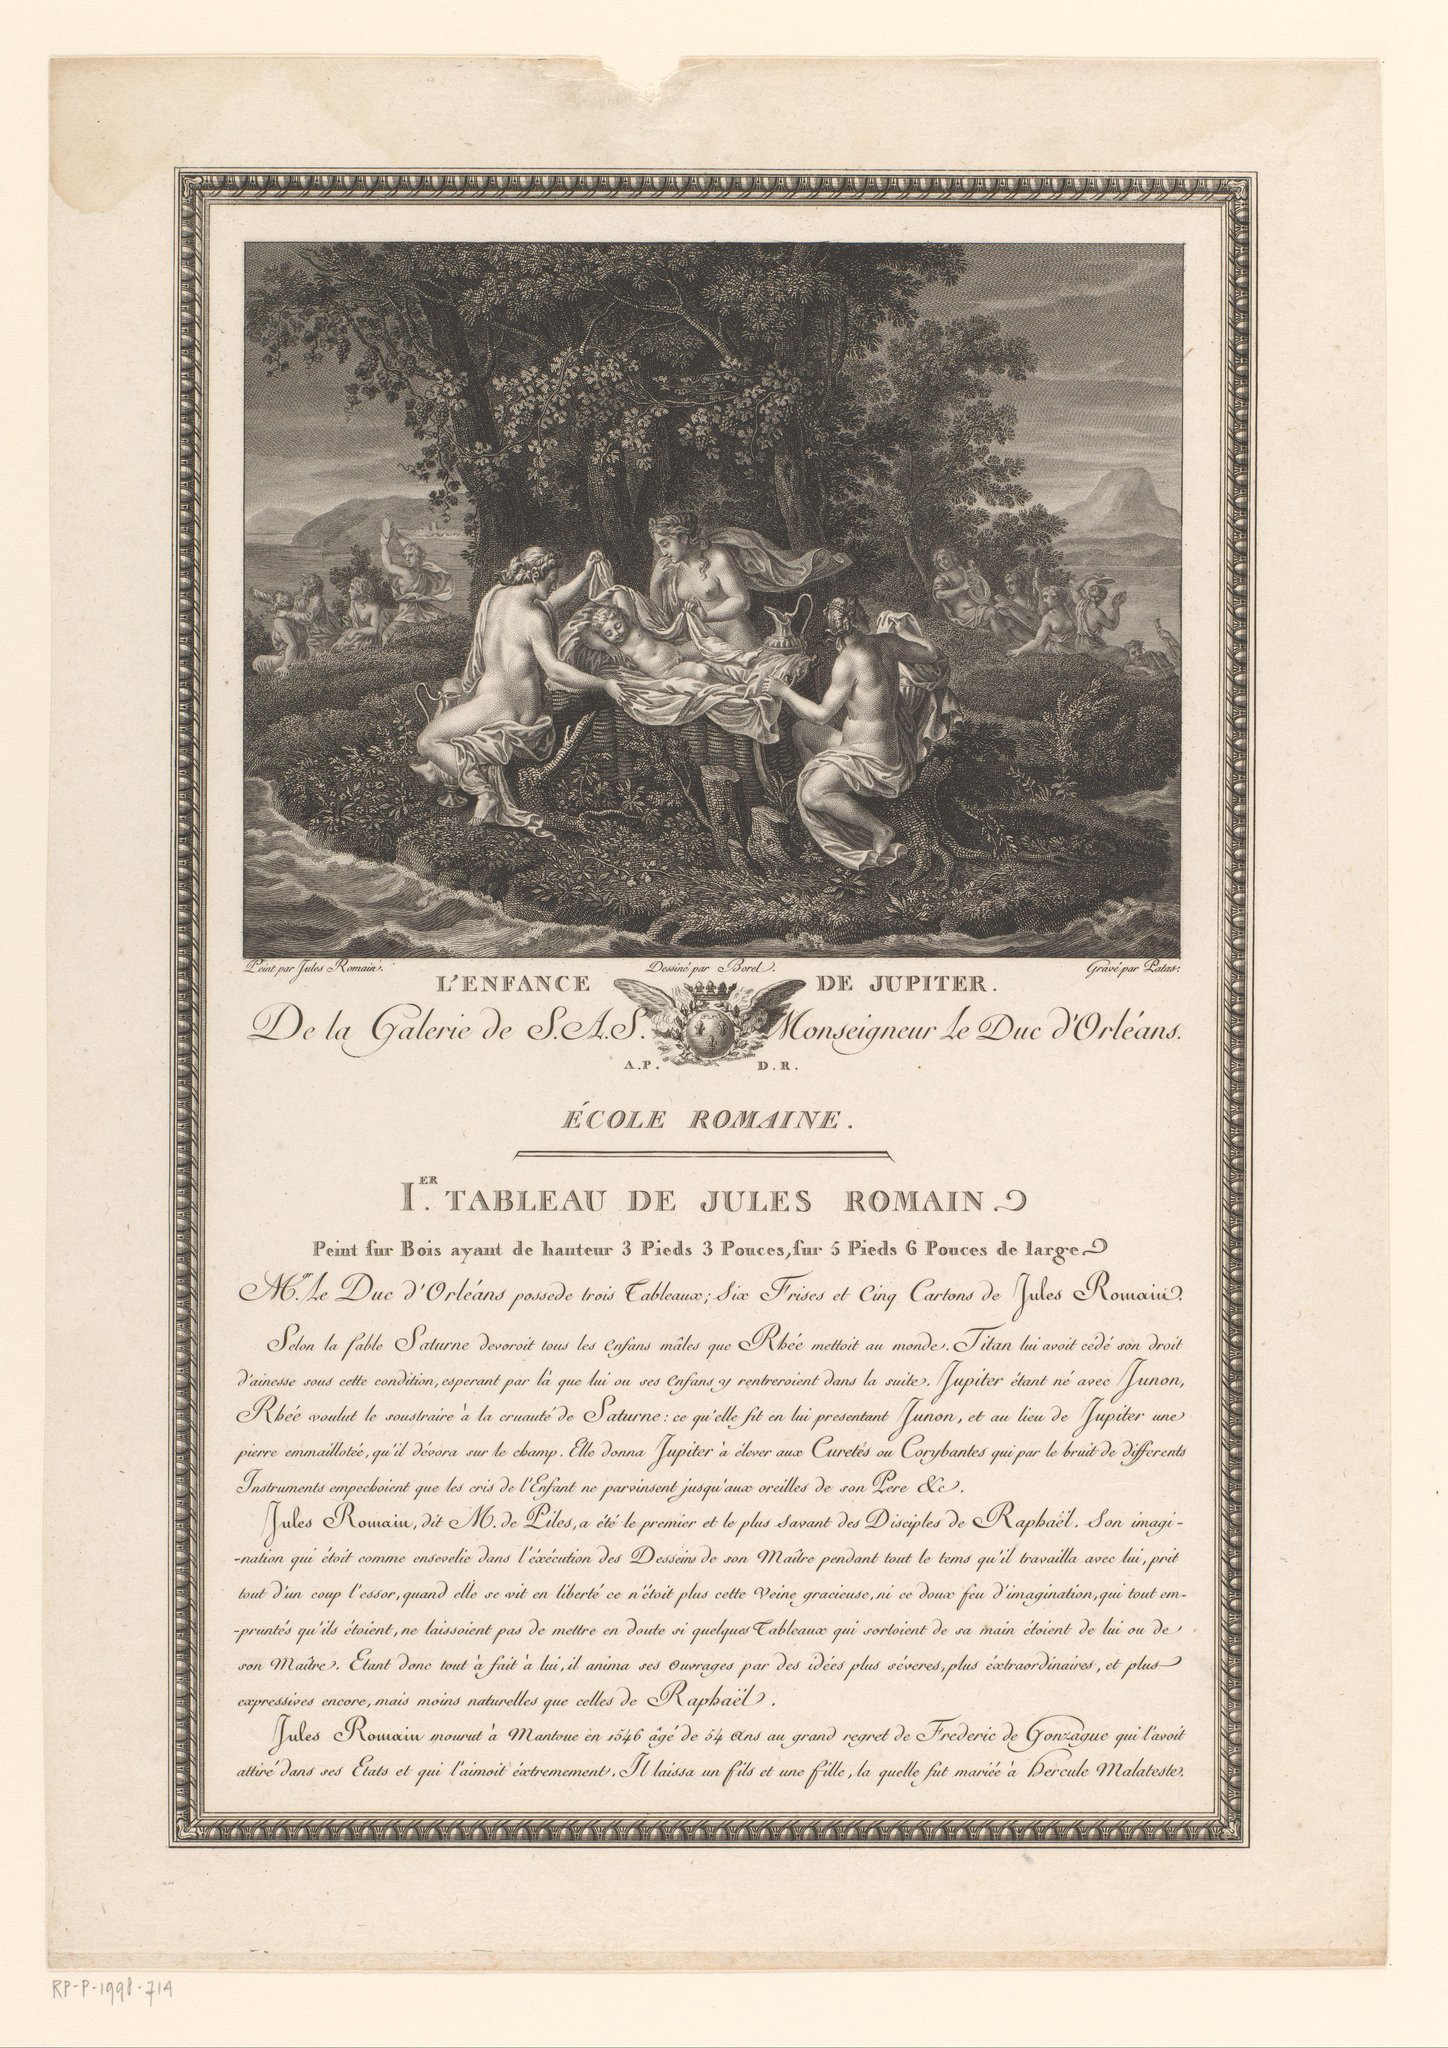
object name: print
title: Opvoeding van Zeus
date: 1786-1808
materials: paper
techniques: engraving, etching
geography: paris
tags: infancy, upbringing of jupiter, nymphs (in general); 'ninfe in commune' (ripa)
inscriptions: collector's mark: Lugt 2228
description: Onderdeel van een serie van 354 prenten naar schilderijen uit de collectie van de Hertog van Orléans, getiteld: La Galerie du Palais Royal, uitgebracht tussen 1786 en 1808. De serie werd uitgegeven door Jacques Couché die het project samen met Jacques Bouillard leidde.